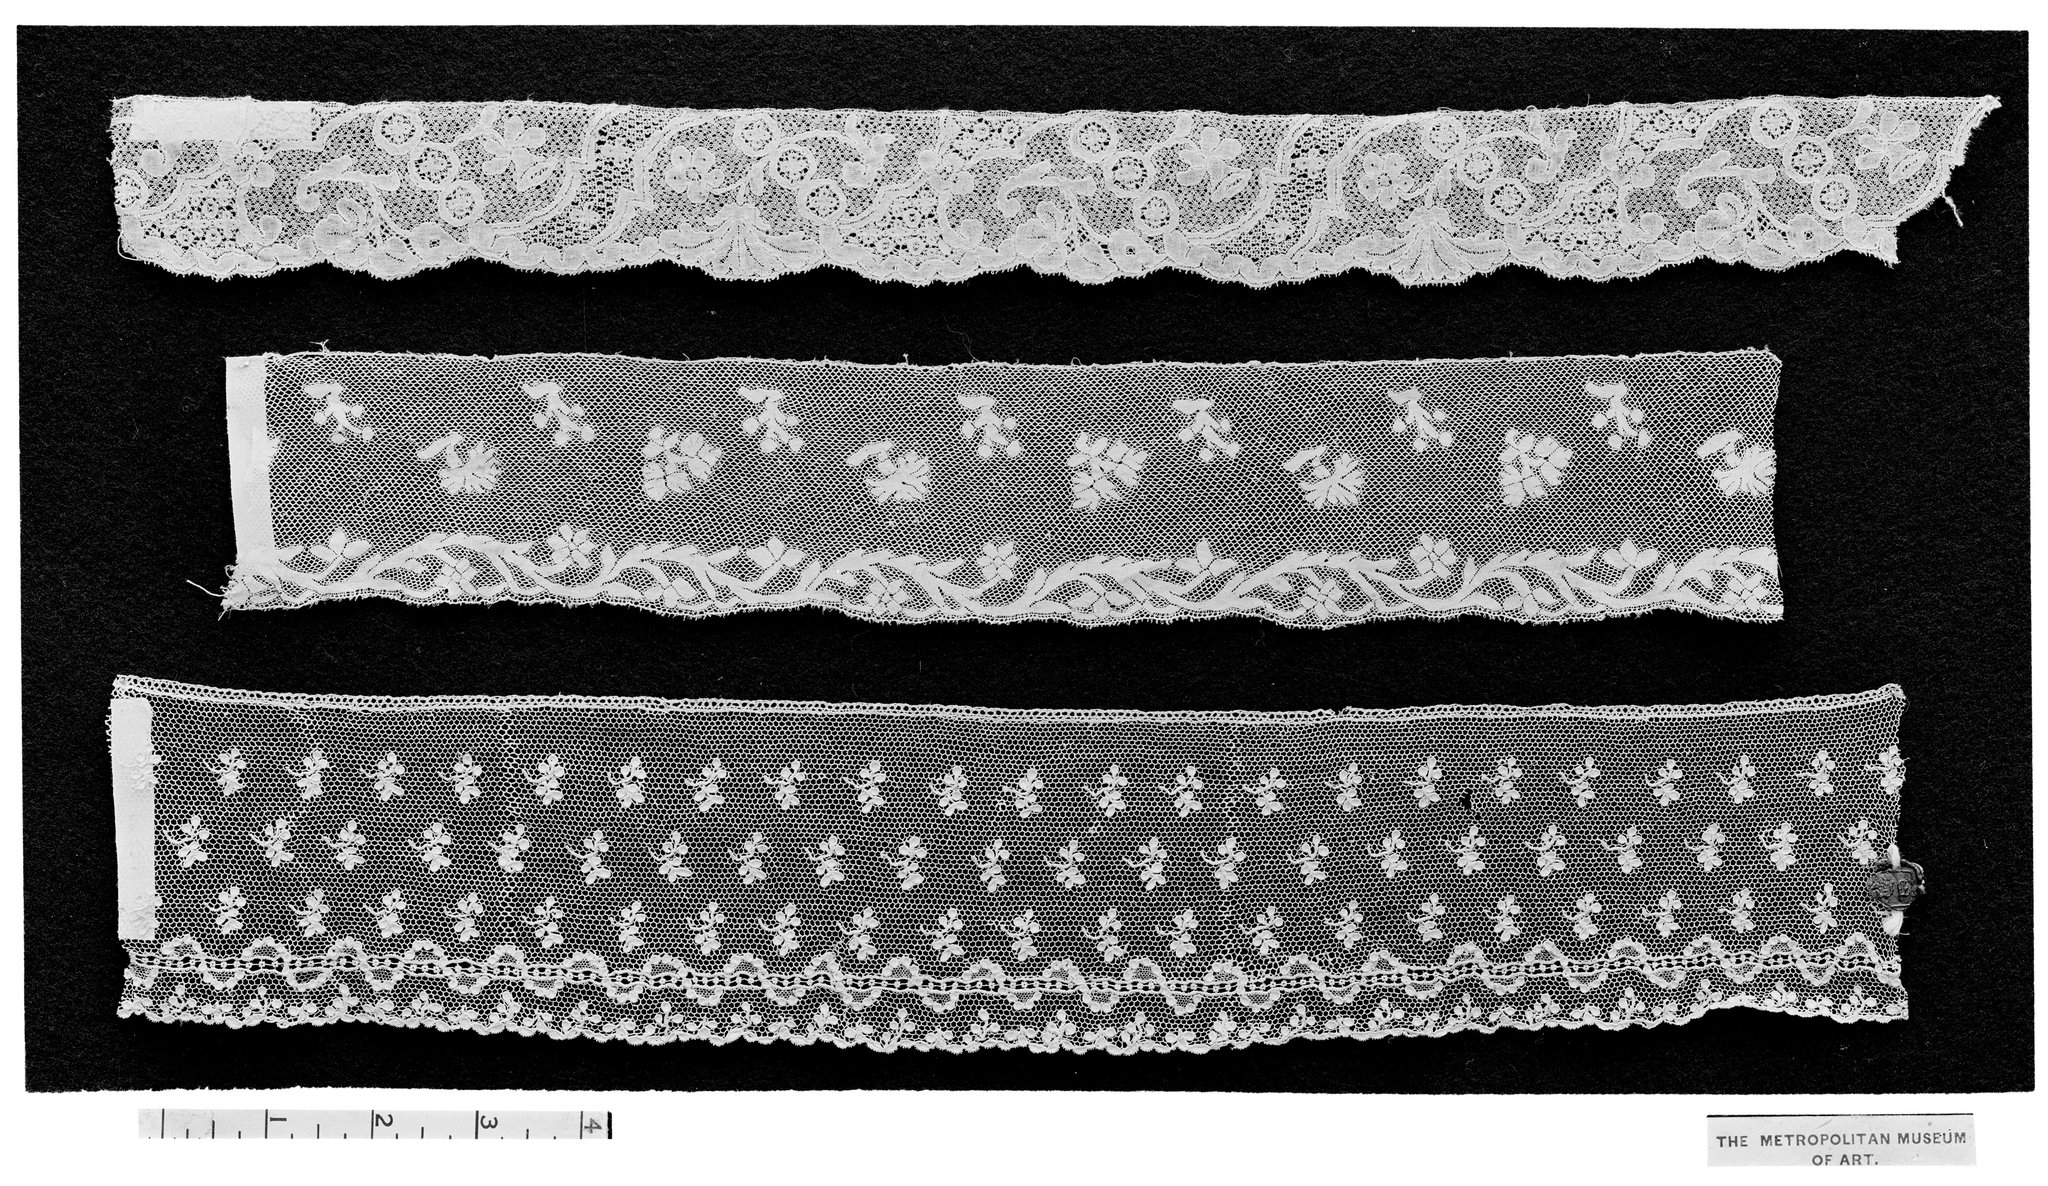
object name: fragment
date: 1767-1800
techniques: lace